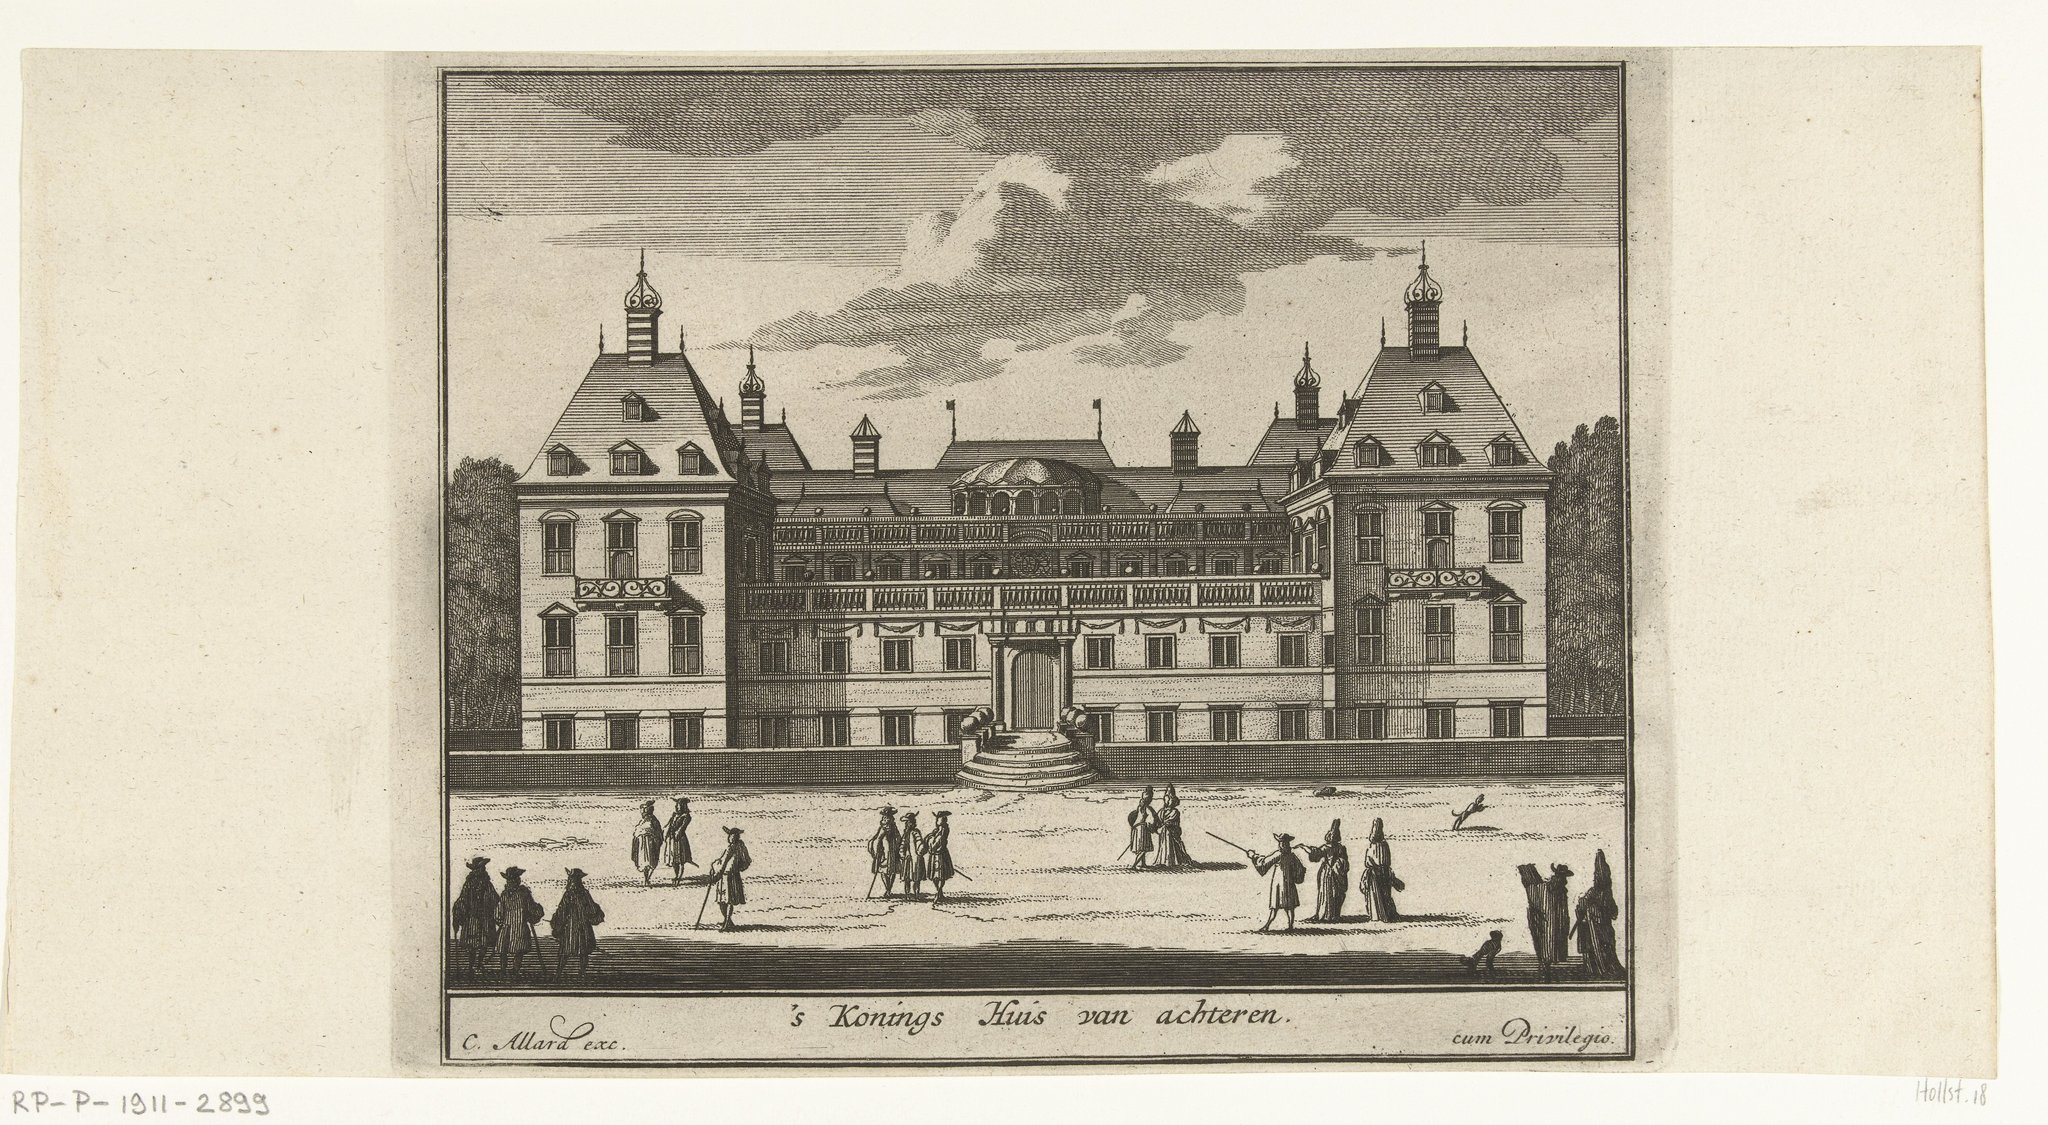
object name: print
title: 's Konings huis van achteren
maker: carel allard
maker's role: print maker, publisher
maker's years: 1648-1709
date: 1689-1702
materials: paper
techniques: engraving, etching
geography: amsterdam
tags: palace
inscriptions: collector's mark: Lugt 2228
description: Achtergevel van Paleis Honselaarsdijk met op het plein achter het paleis groepjes wandelaars. Prent uit een serie van zeventien prenten van Paleis Honselaarsdijk.